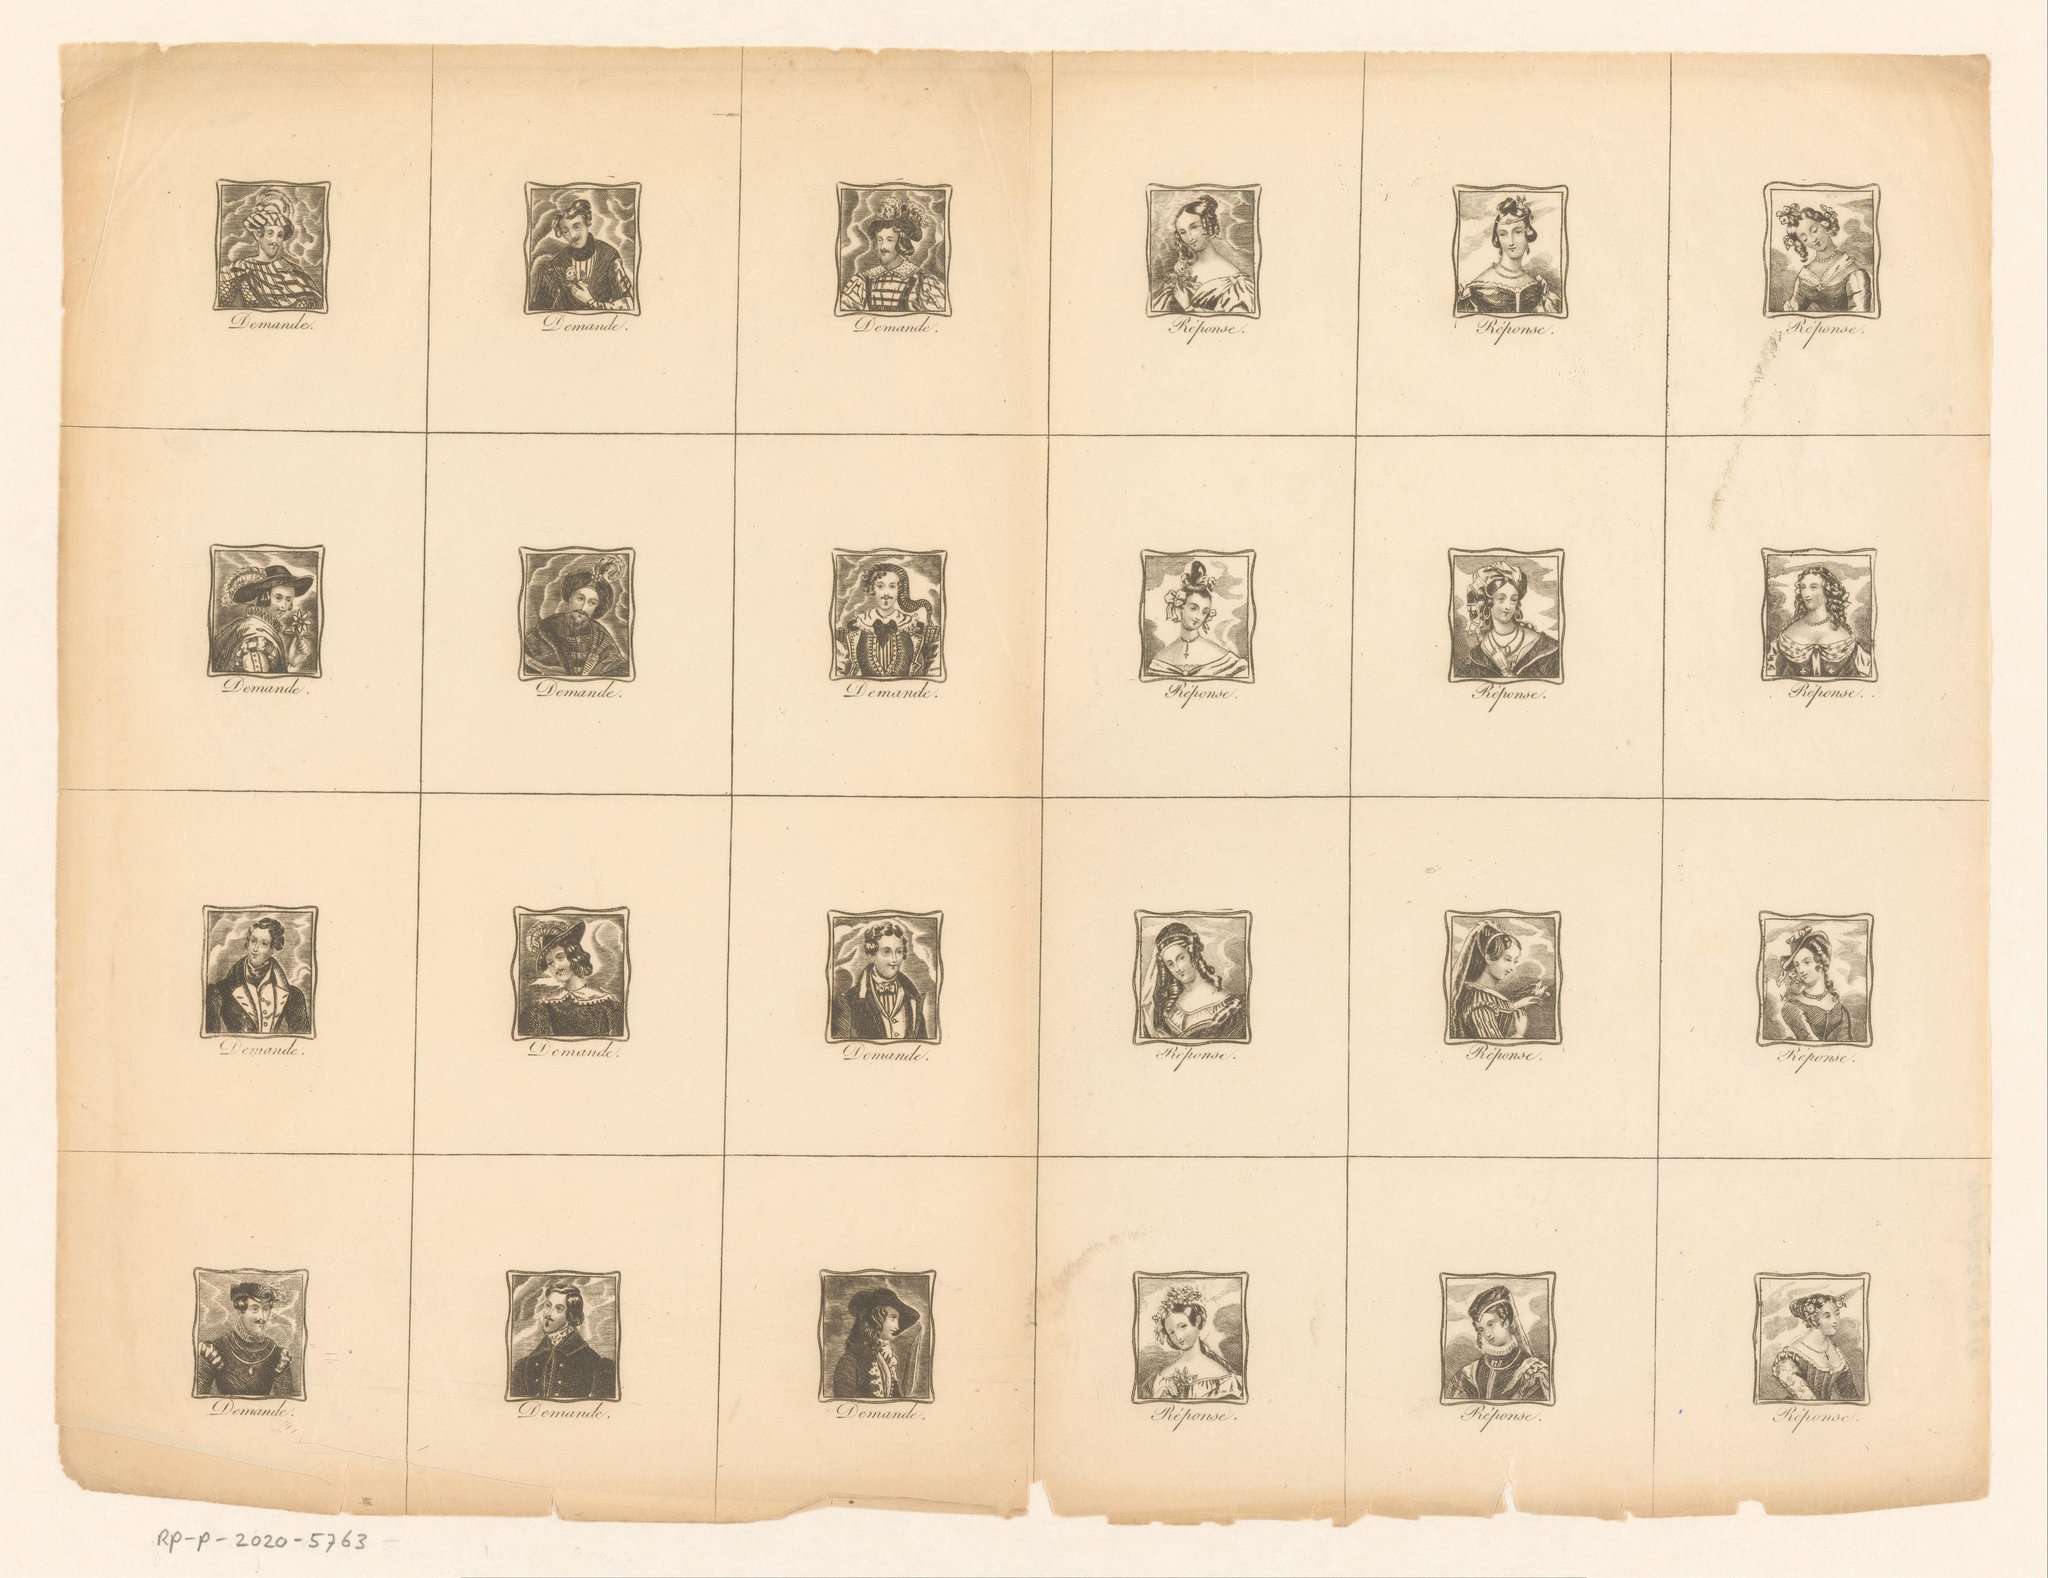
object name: print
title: Demande. / Réponse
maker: Anonymous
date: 1800-1899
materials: paper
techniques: lithograph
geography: france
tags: head (human), games of calculation and chance, e.g.: card games, gambling, puzzles, etc., head (human) - aa - female human figure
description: Links staan de twaalf mannenhoofden, waaronder 'Demande' staat. Bij de vrouwenhoofden staat er 'Réponse'.